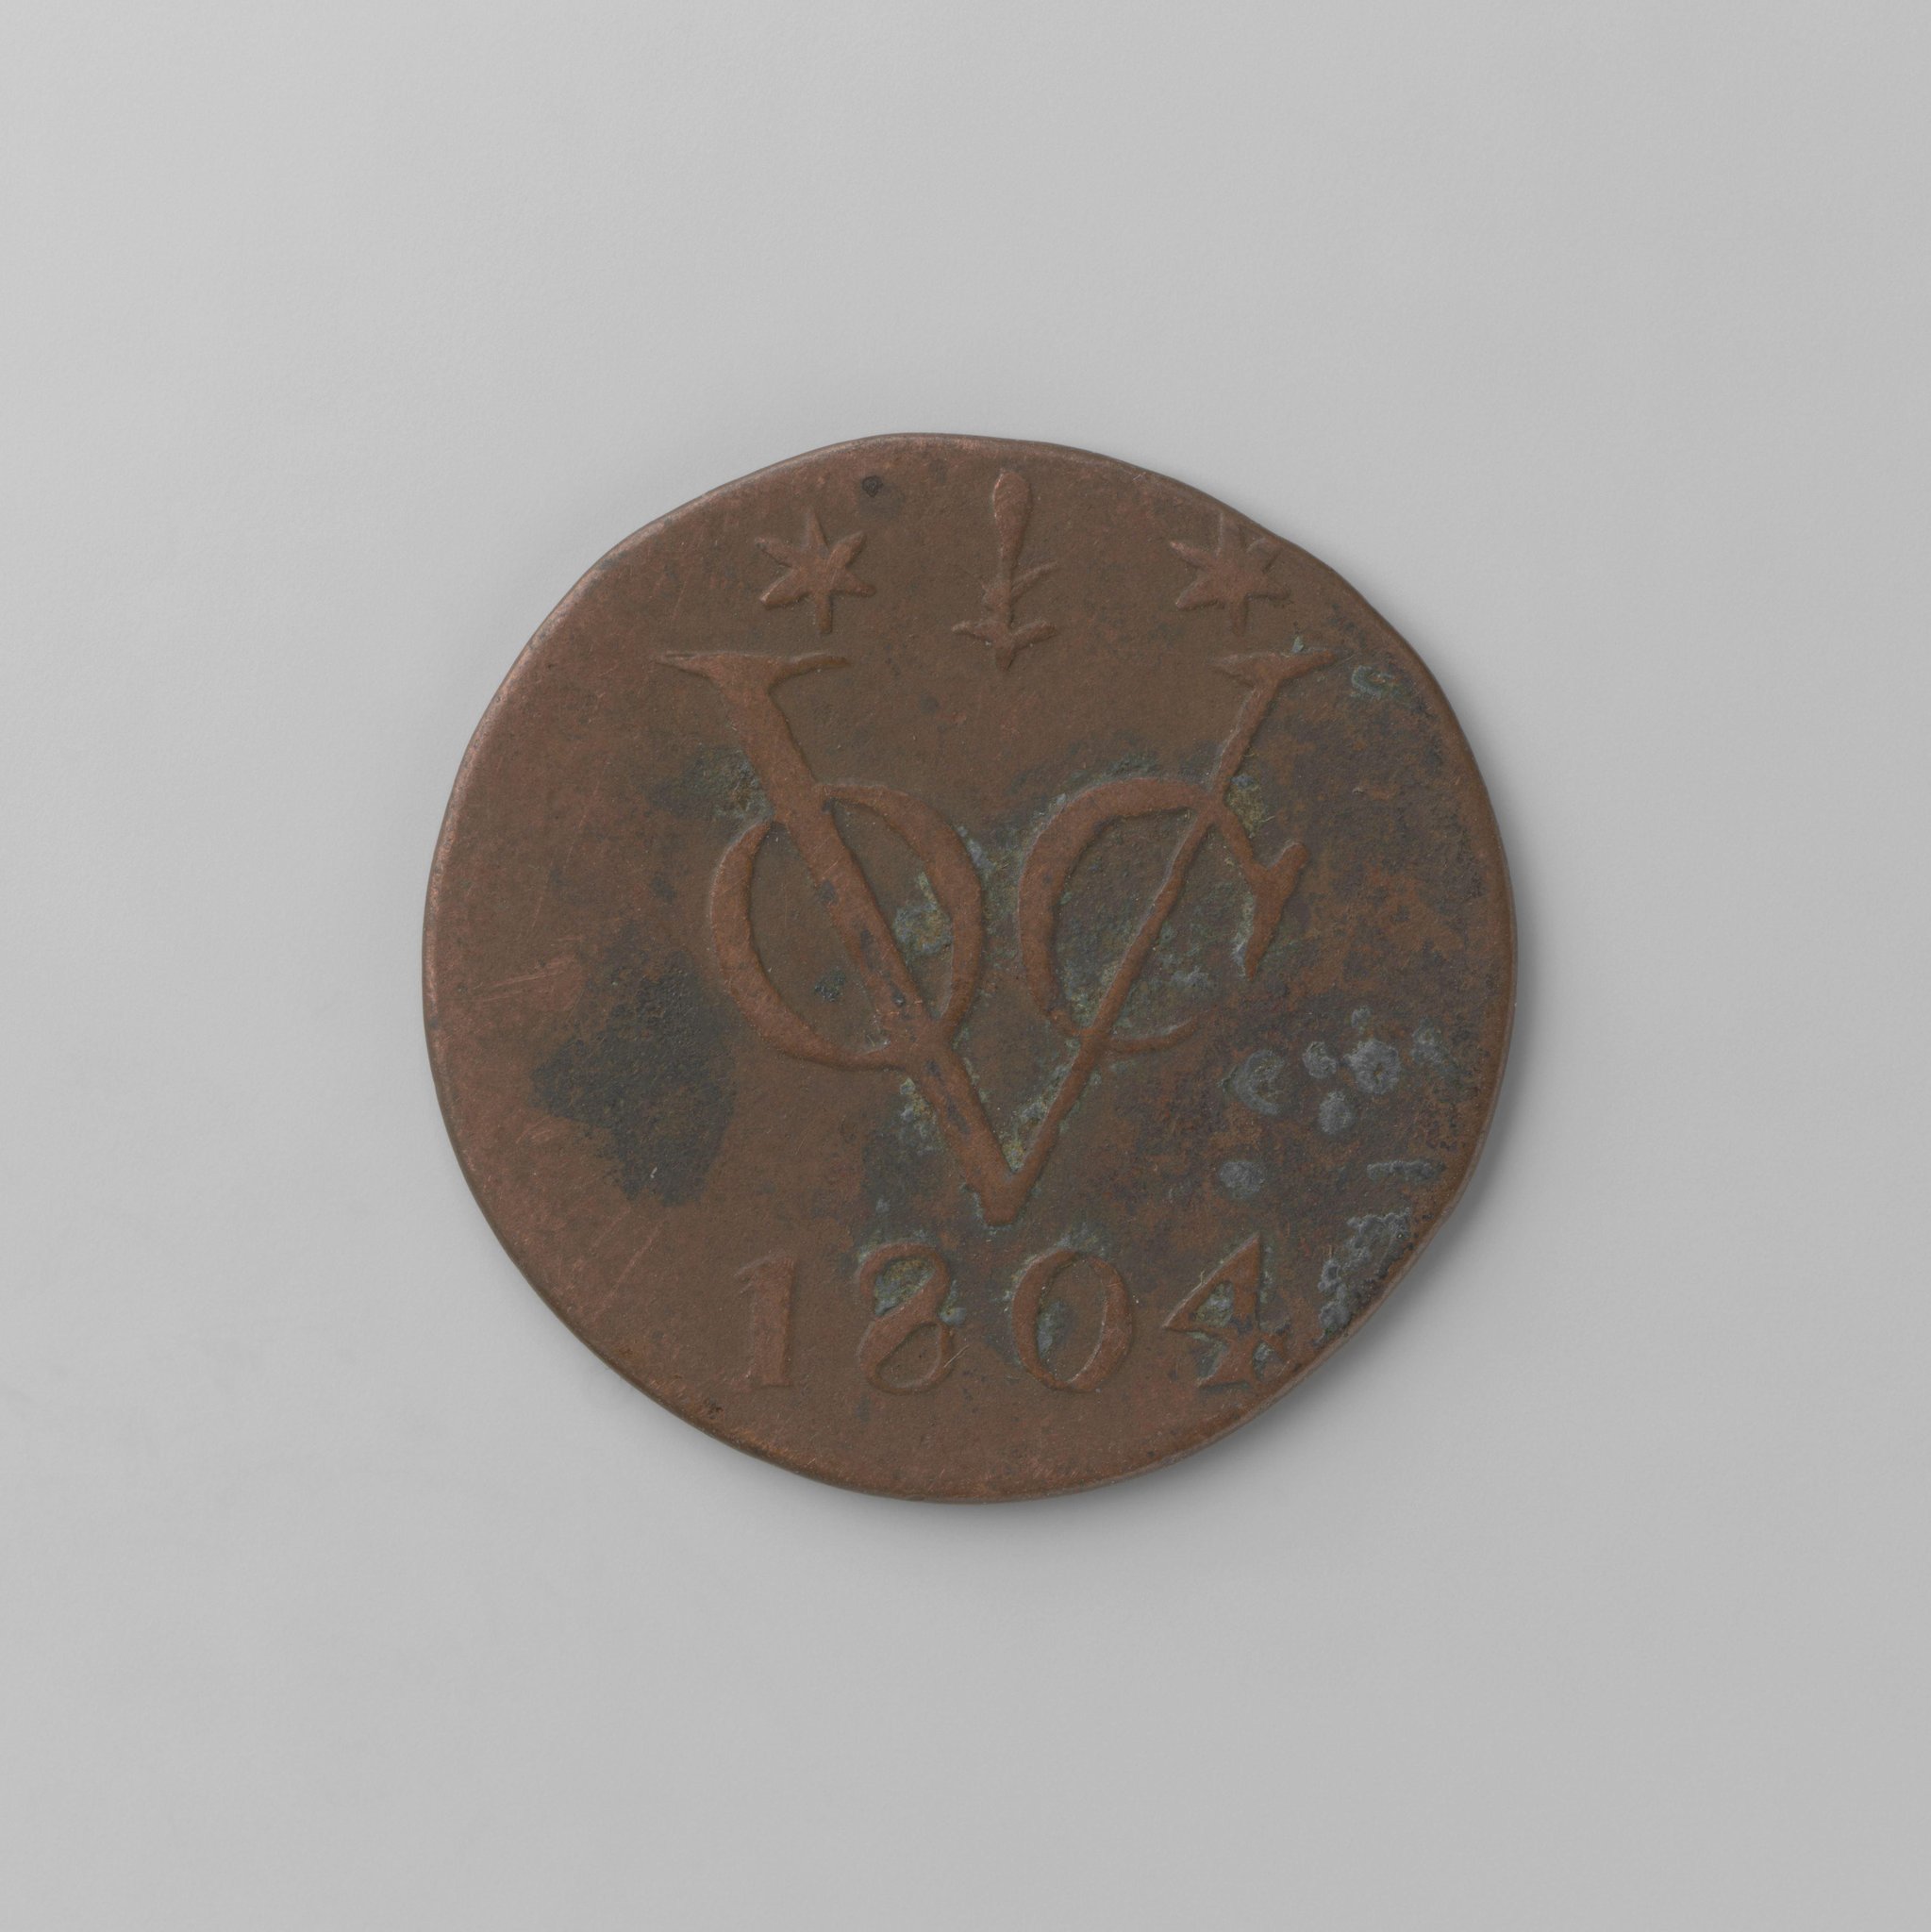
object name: coin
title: Duit voor Nederlands Indië uit Gelderland,1804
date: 1804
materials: copper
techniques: striking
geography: harderwijk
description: Koperen munt. Voorzijde: tussen wapenspreuk gekroond wapenschild van Gelderland. Keerzijde: monogram van de VOC, waarboven muntmeesterteken en waaronder jaartal. Gladde rand.